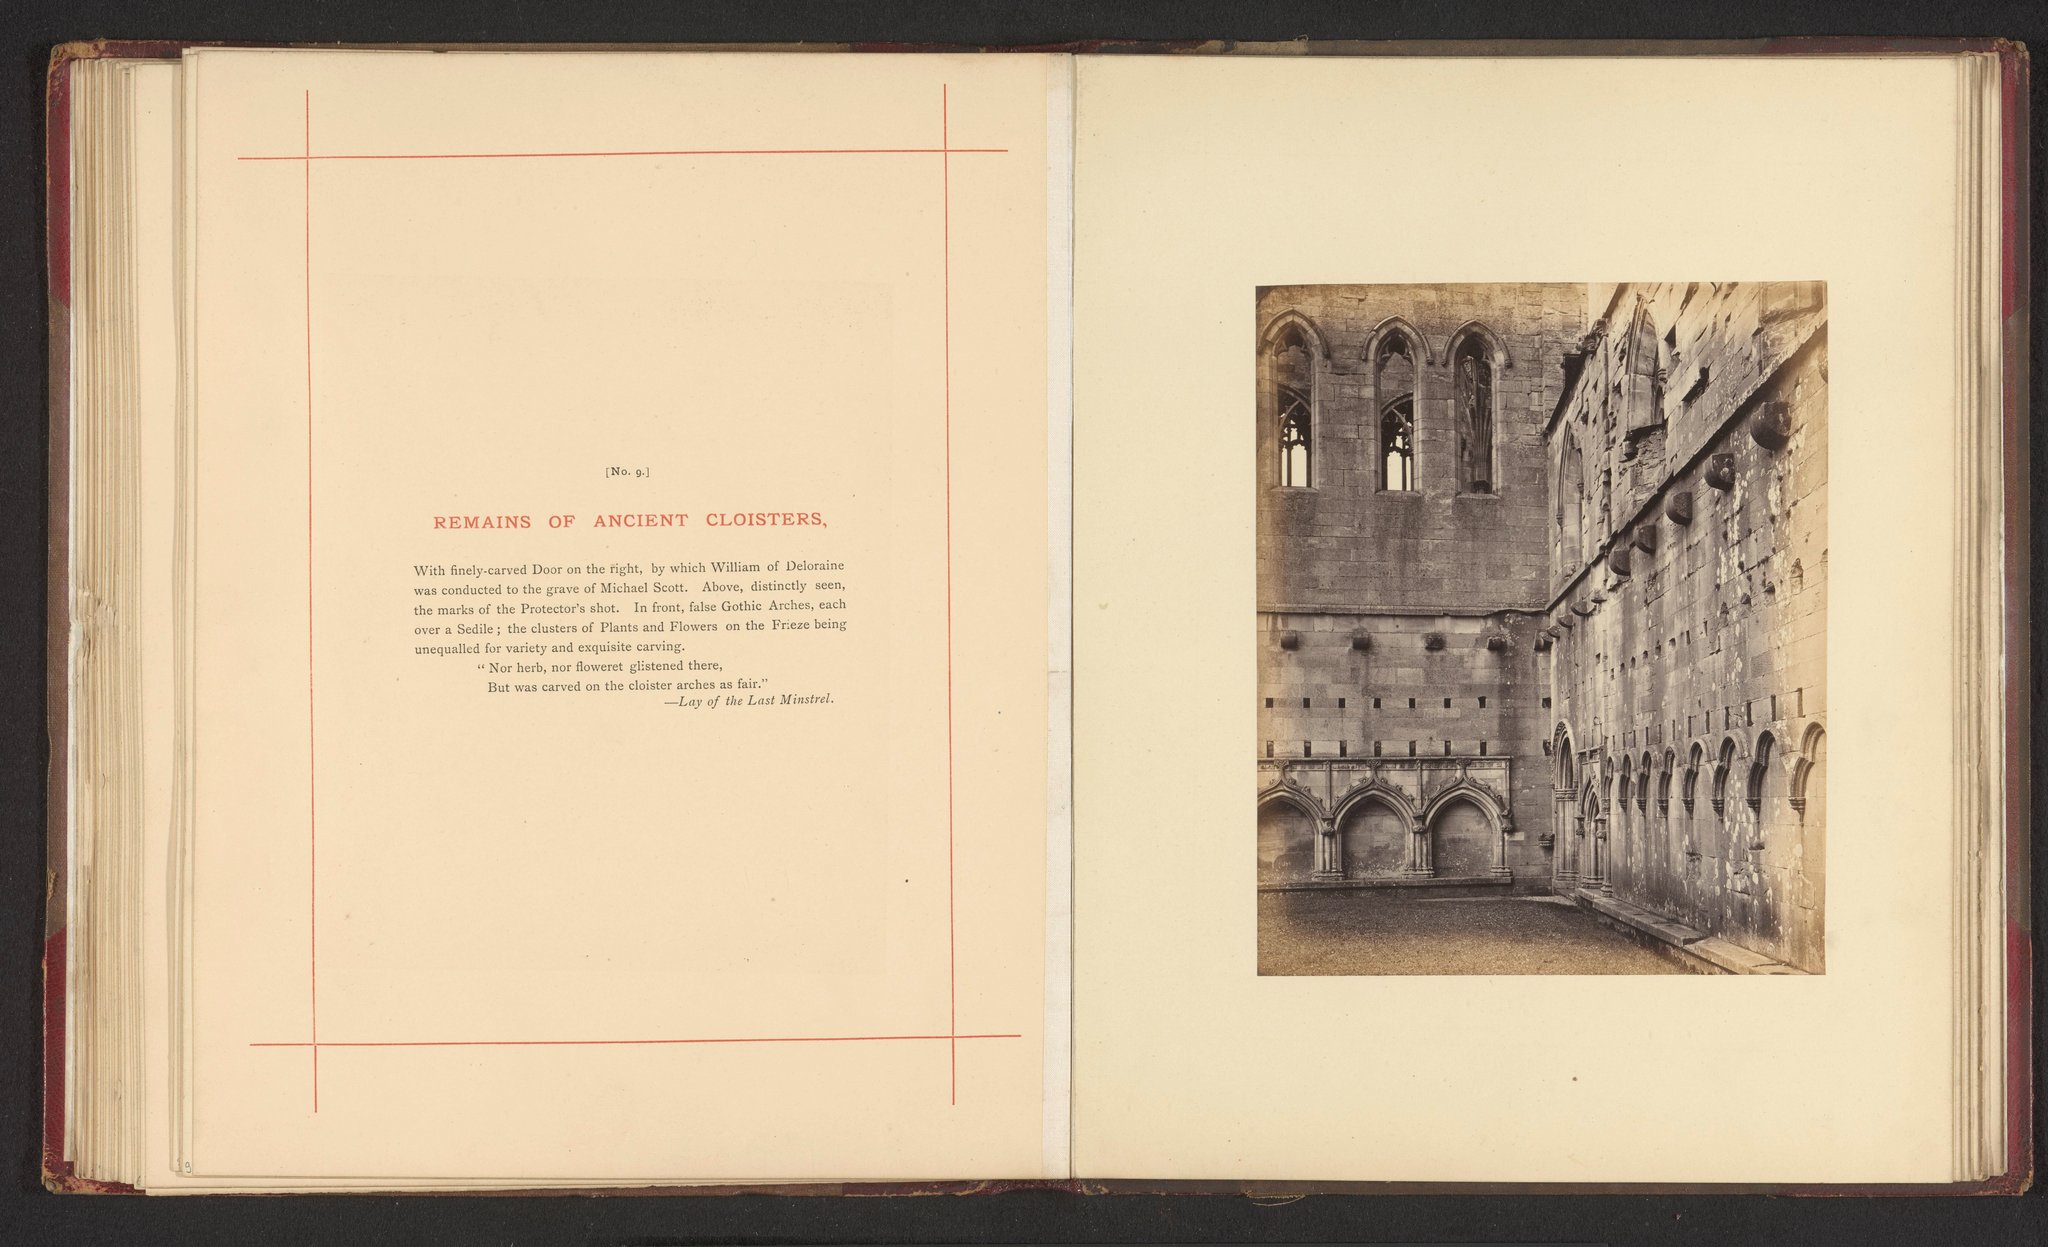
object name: photograph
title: Resten van de kloostergang van Melrose Abbey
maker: w.j. pringle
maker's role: fotograaf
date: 1860-1870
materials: photographic support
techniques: albumen print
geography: melrose abbey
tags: ruin of church, monastery, etc., cloisters ~ monastery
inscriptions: number: ‘(No. 9.)’, inscription: ‘With finely-carved Door on the right (...)’, title: ‘Remains of ancient cloisters’